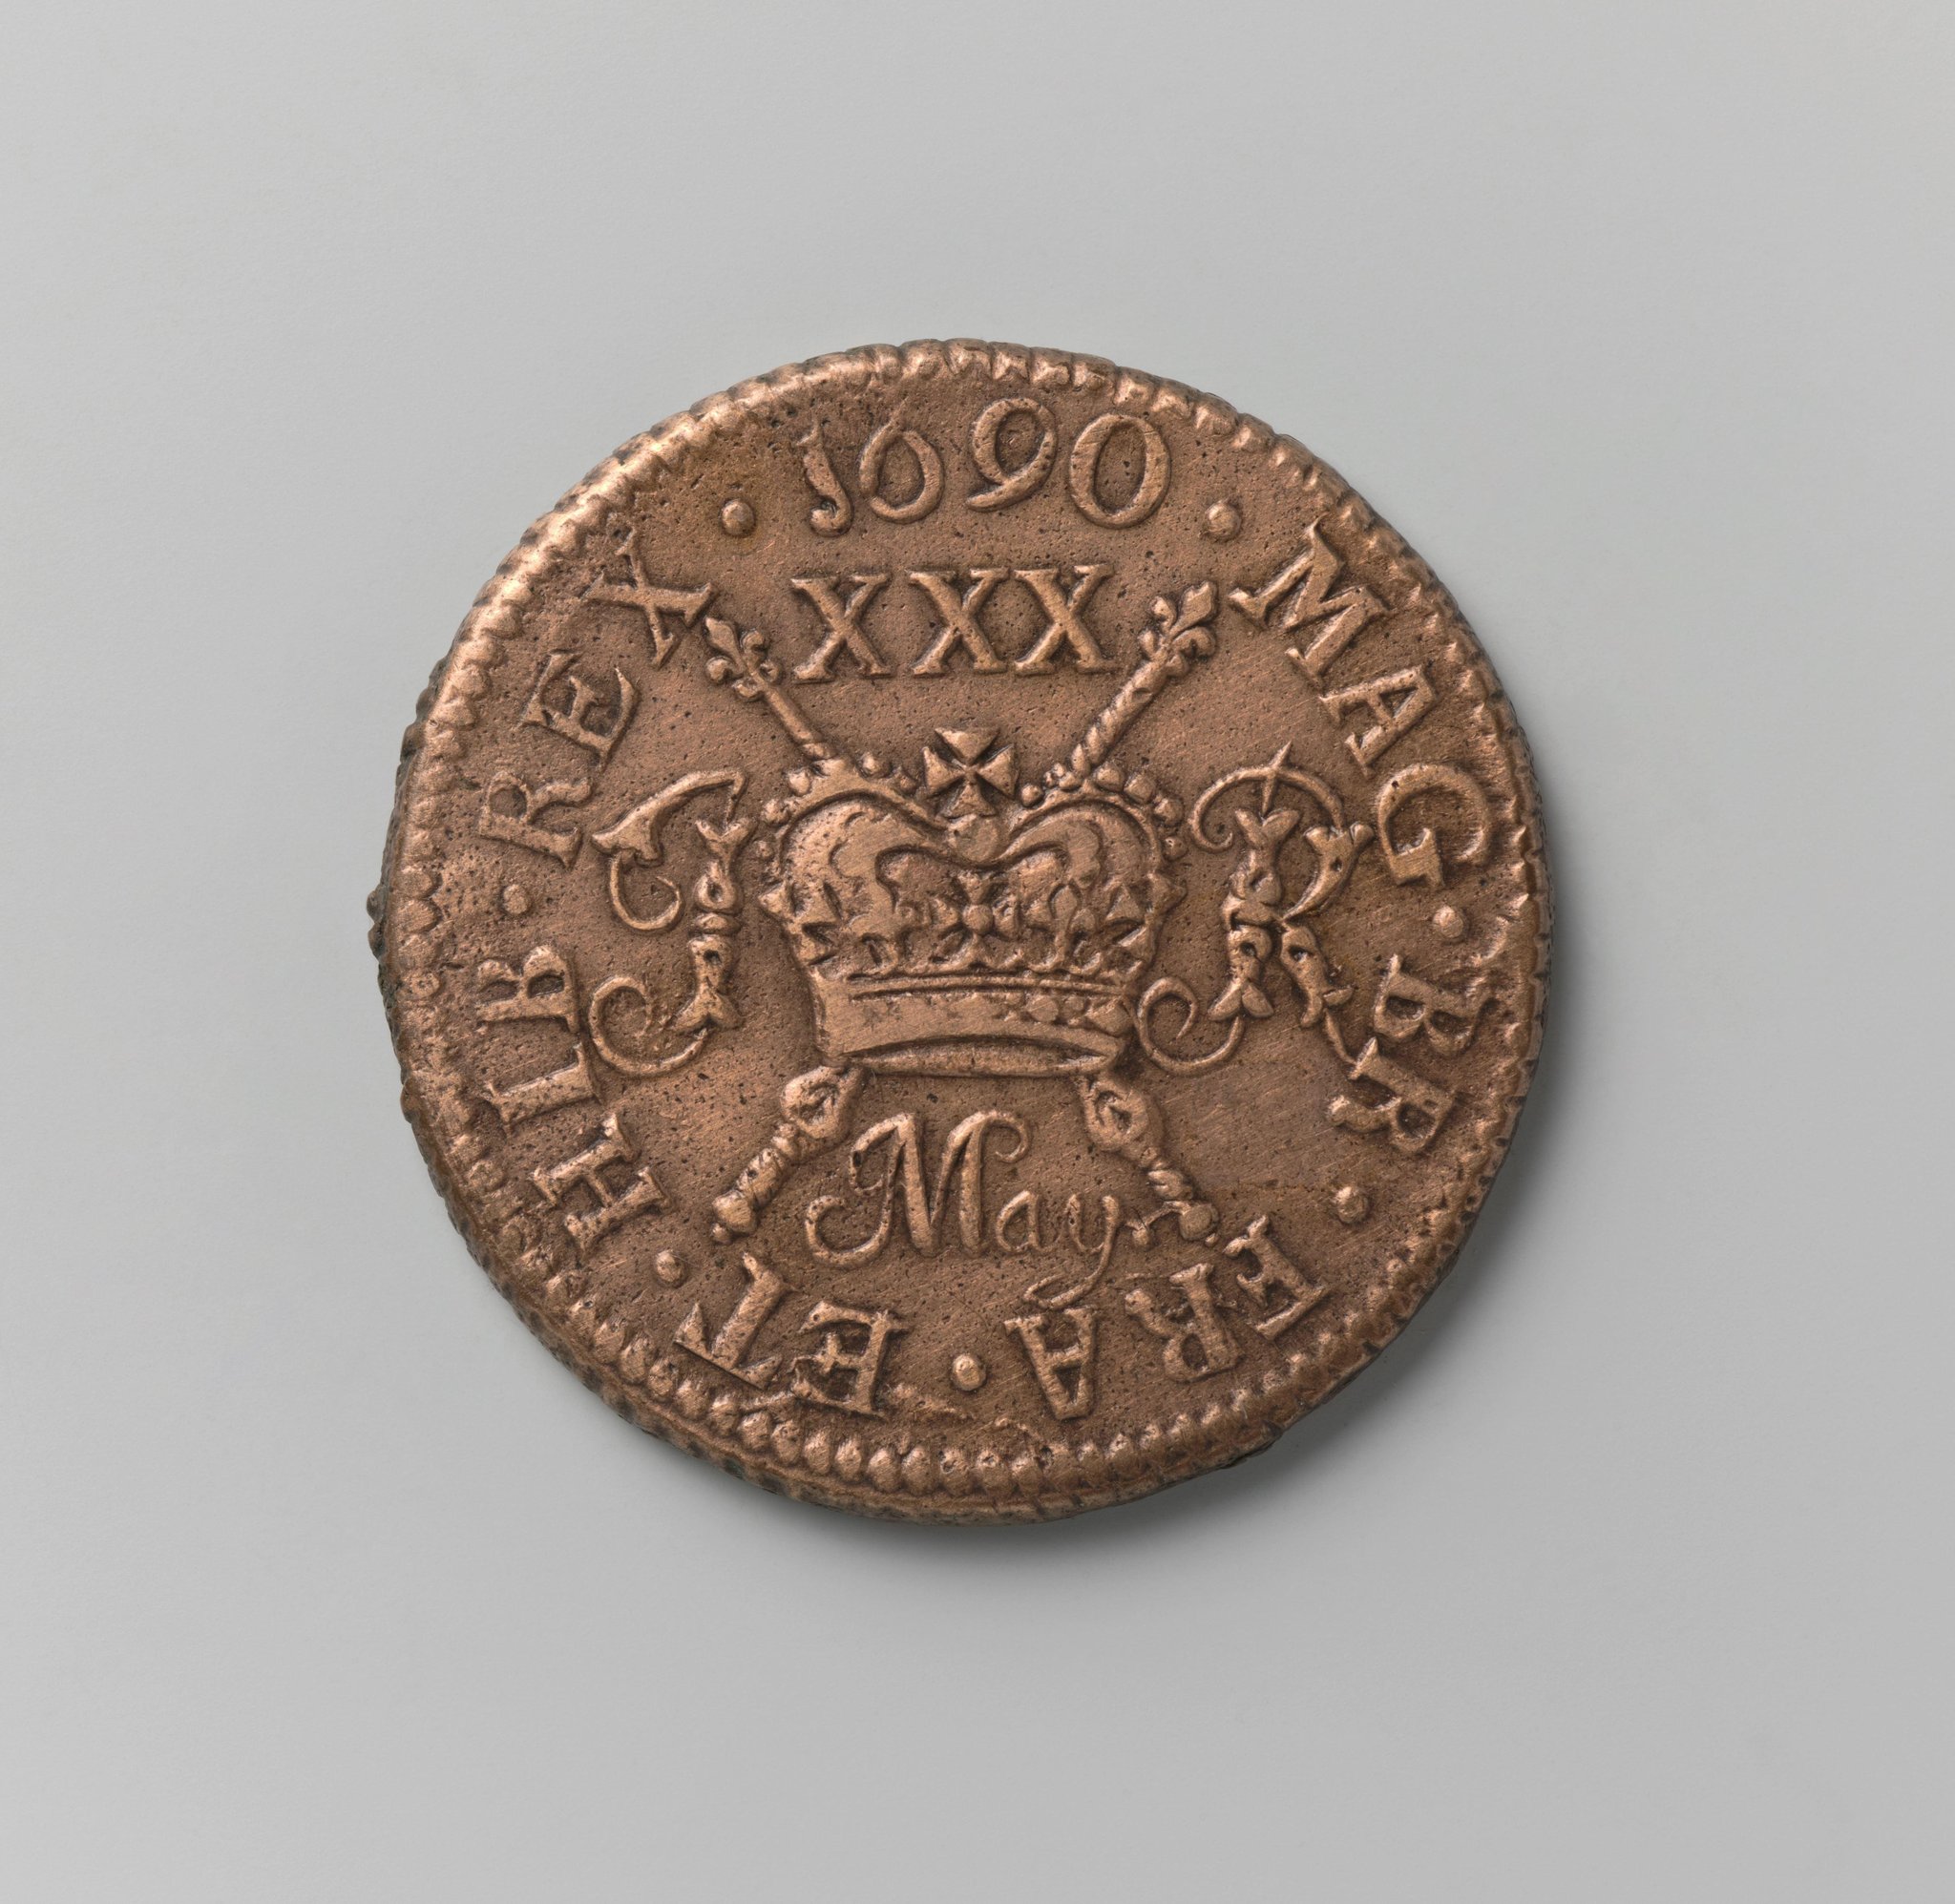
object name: coin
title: Ierland, Jacobus II, ½ crown, mei 1690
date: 1690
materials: bronze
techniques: striking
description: Bronzen munt. Voorzijde: gelauwerd hoofd van de vorst naar links. Keerzijde: tussen letters J en R kroon op twee gekruiste scepters.Jaartal bovenaan in omschrift, maand-aanduiding onder kroon, Waarde-aanduiding XXX [pence] boven kroon. Kabelrand. Gun-money.